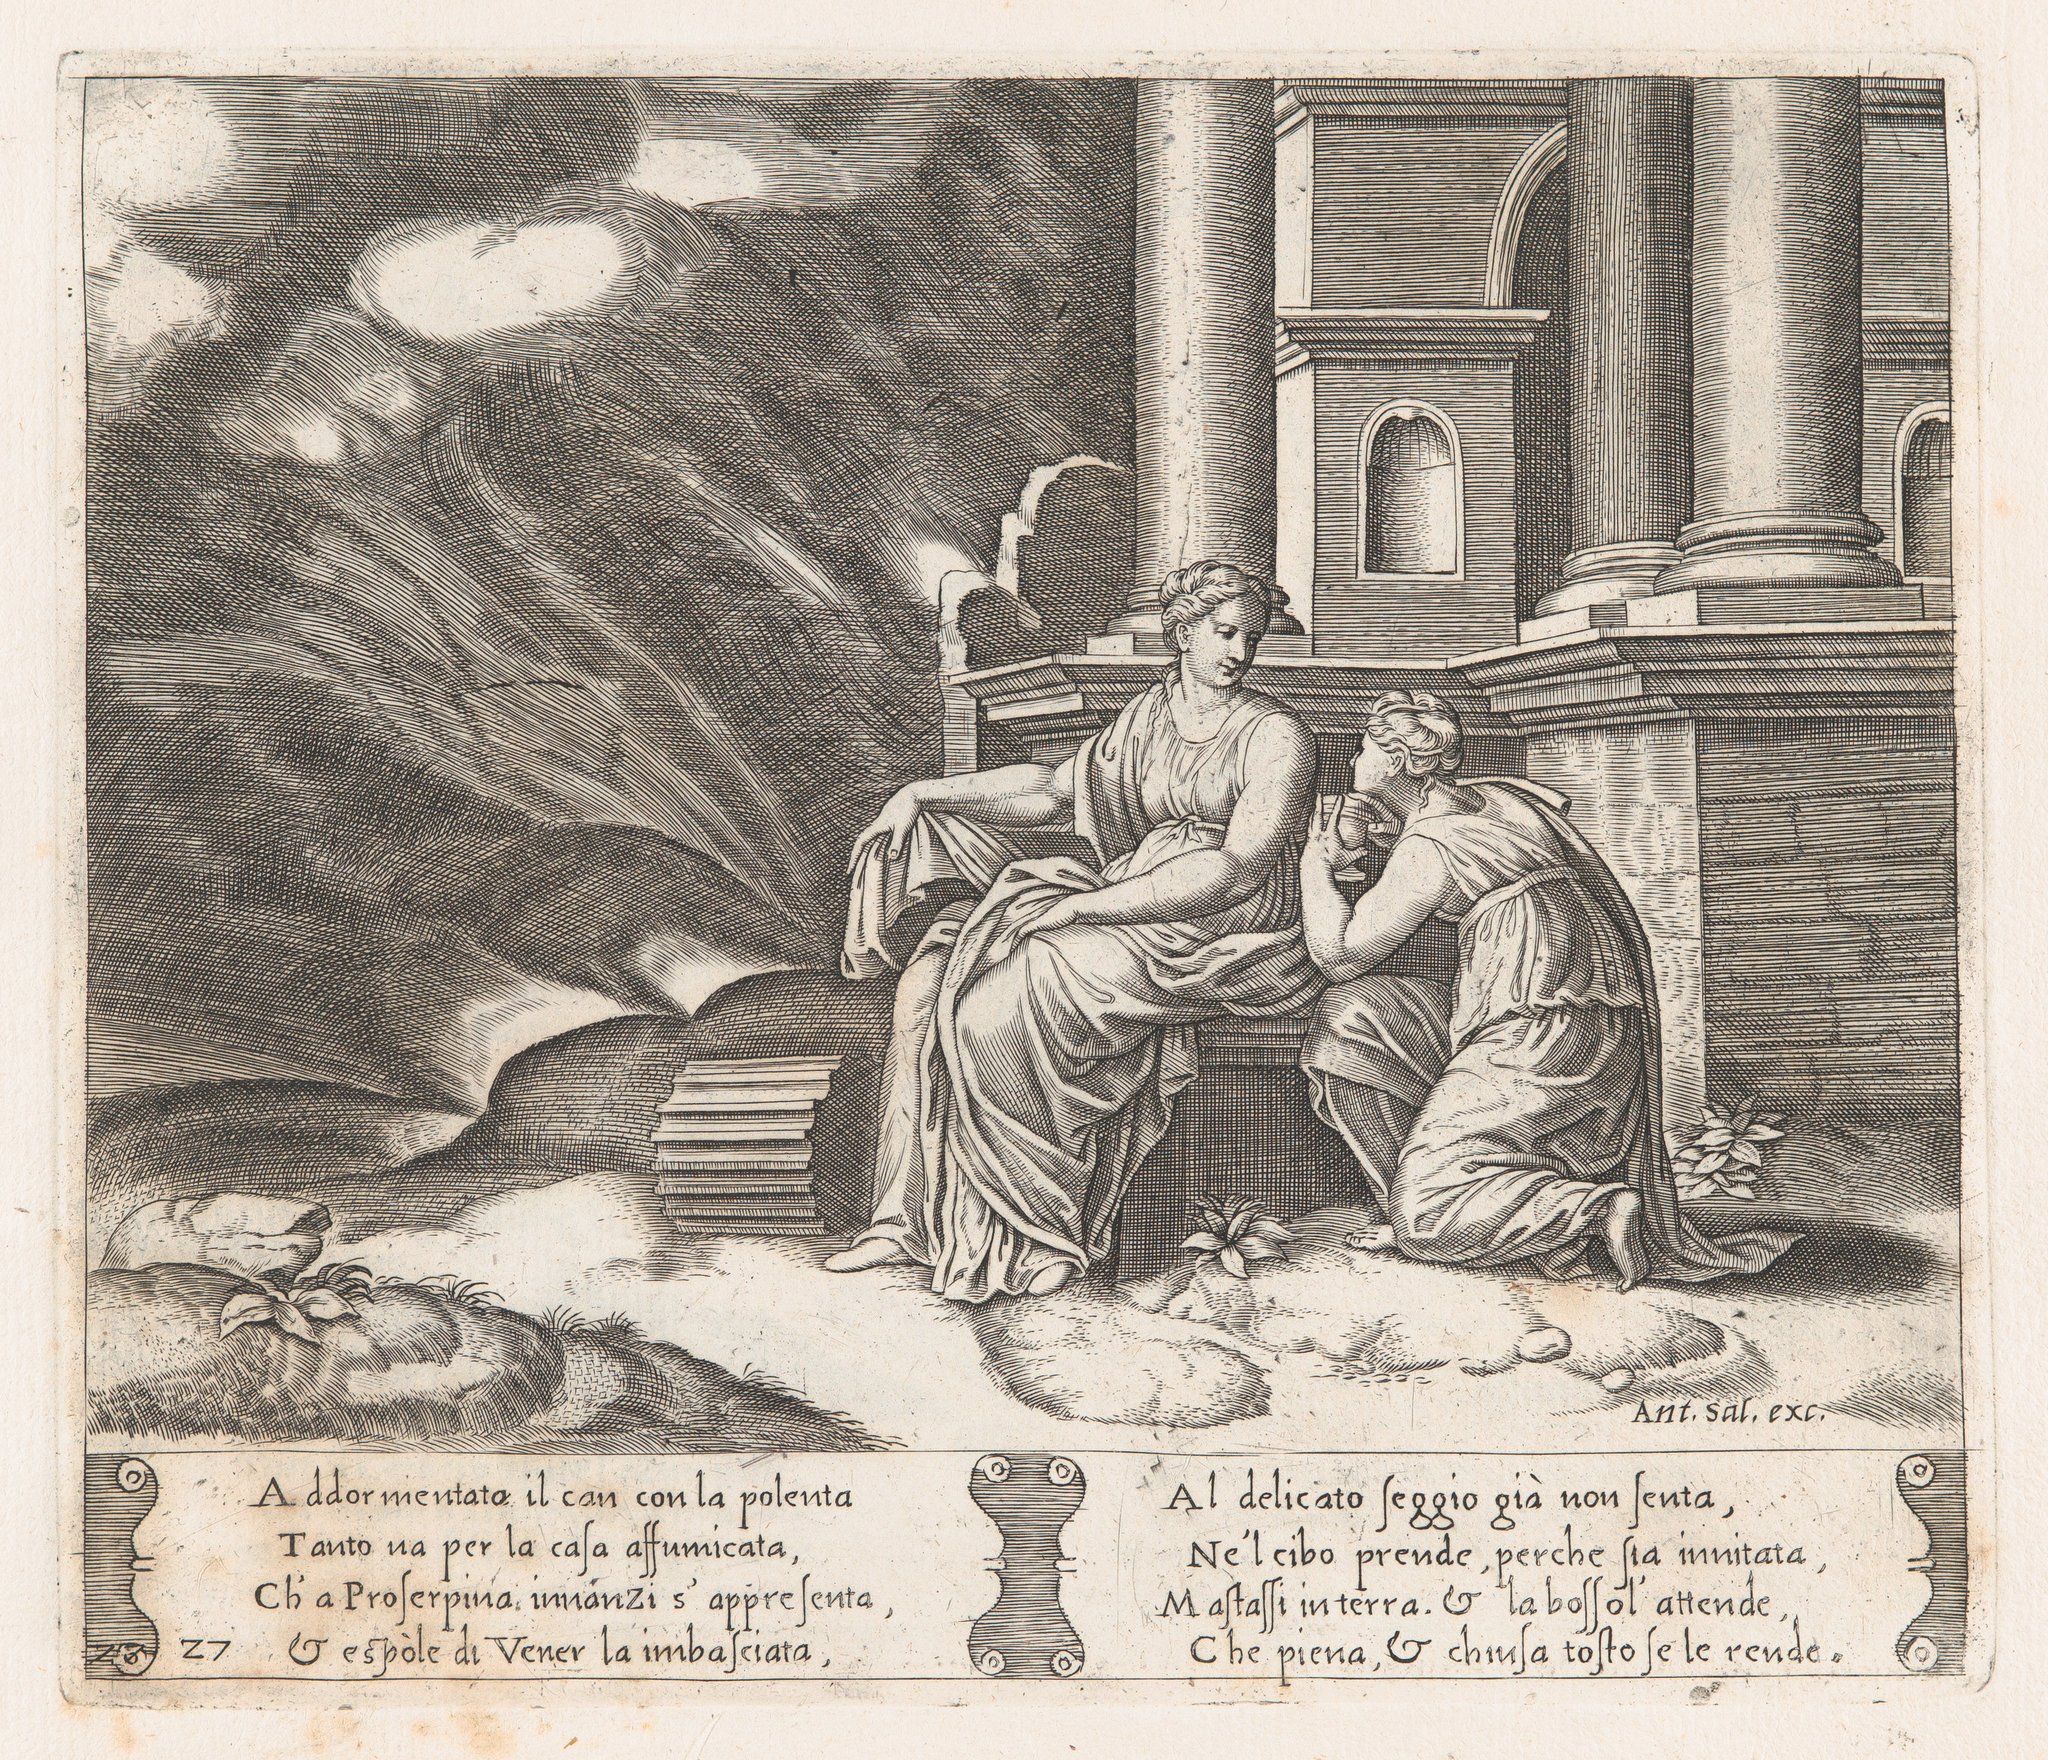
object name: print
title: Plate 27: Proserpine gives Psyche the box of beauty, from "The Story of Cupid and Psyche as told by Apuleius"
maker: master of the die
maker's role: artist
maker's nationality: italian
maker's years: 1525-1560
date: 1530-1560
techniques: engraving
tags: women,psyche